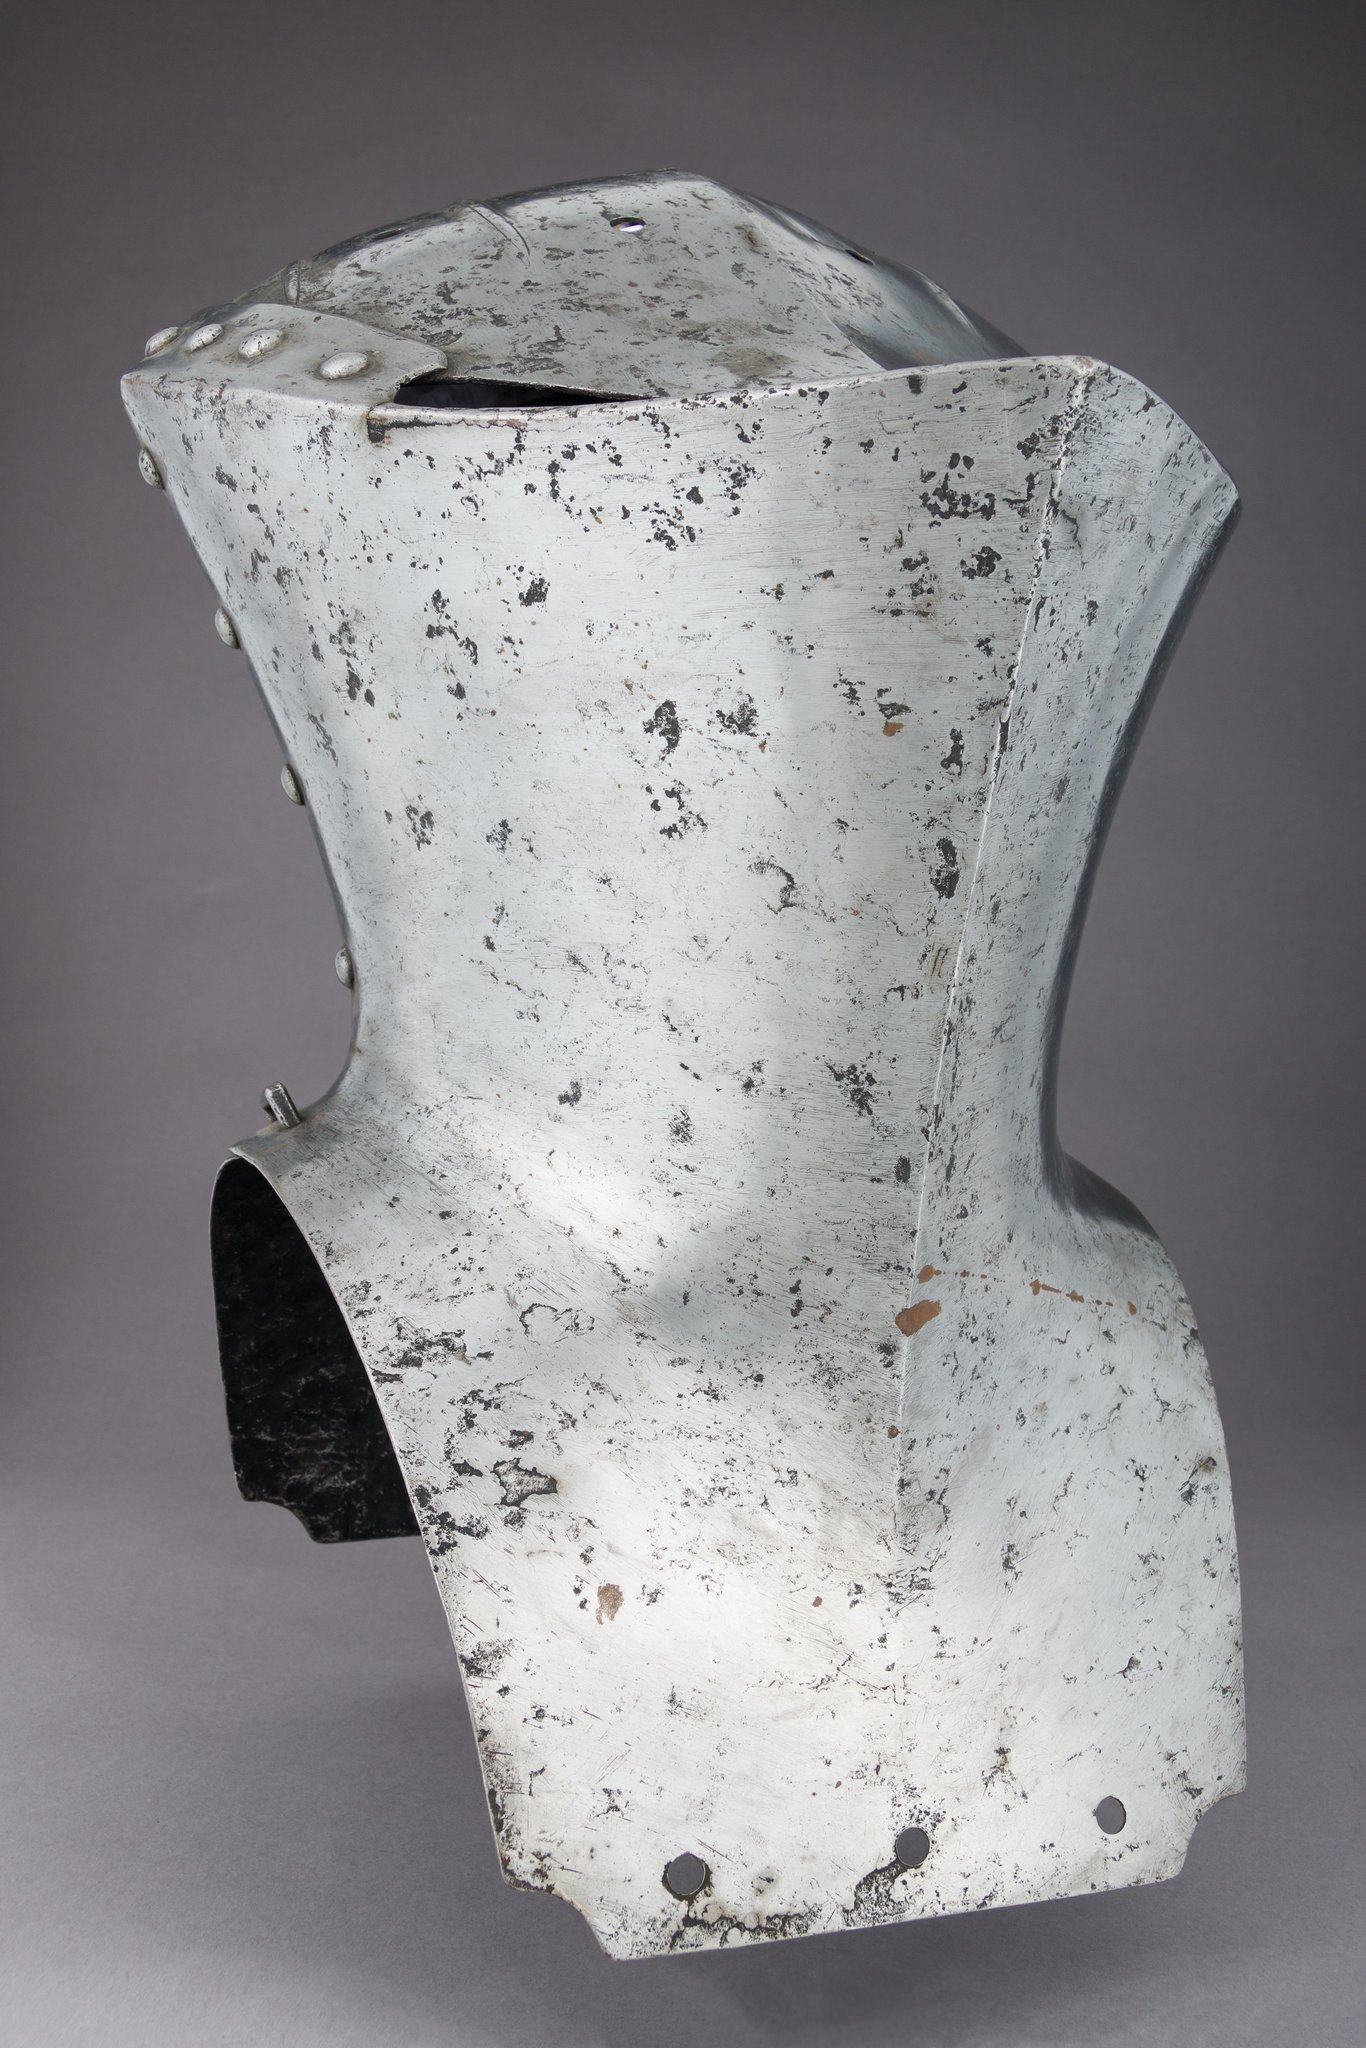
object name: jousting helmet in late 15th century style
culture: german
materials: steel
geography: germany